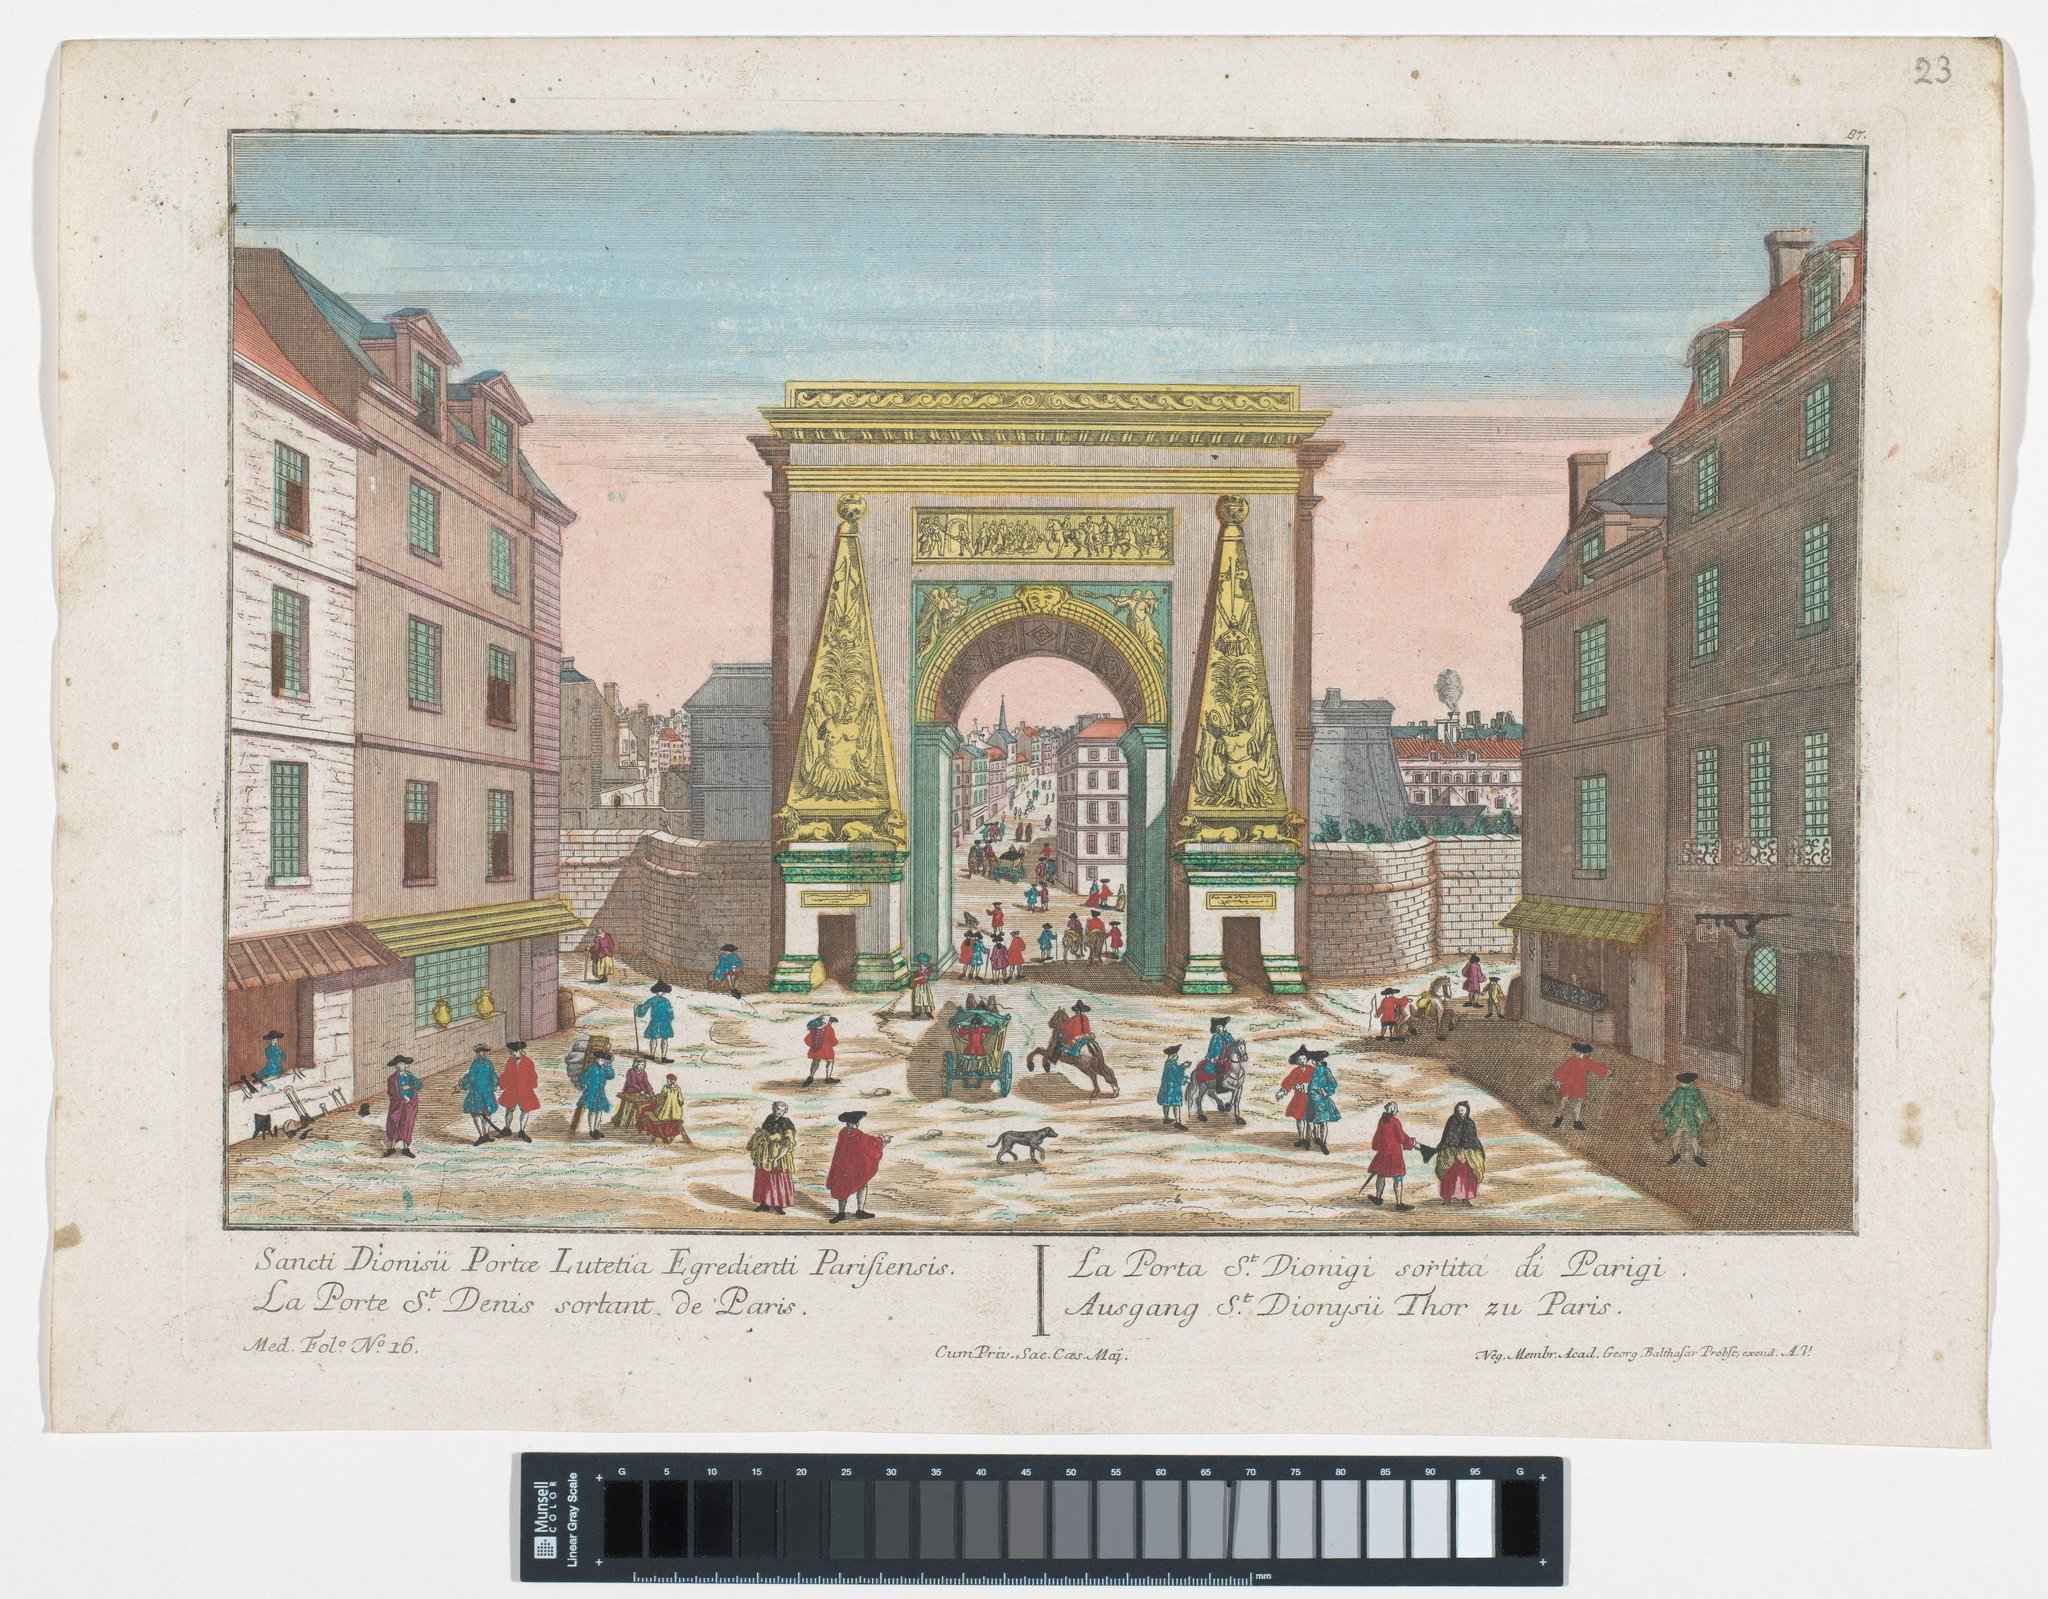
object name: print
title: Gezicht op de Porte Saint-Denis te Parijs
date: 1742-1801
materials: paper, watercolor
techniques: brush, etching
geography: germany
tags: triumphal arch, street (+ city(-scape) with figures, staffage)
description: De serie “Parijs”, met het nummer 16, bevat vier prenten met de nummers 87-90, waarvan dit nummer 87 is.